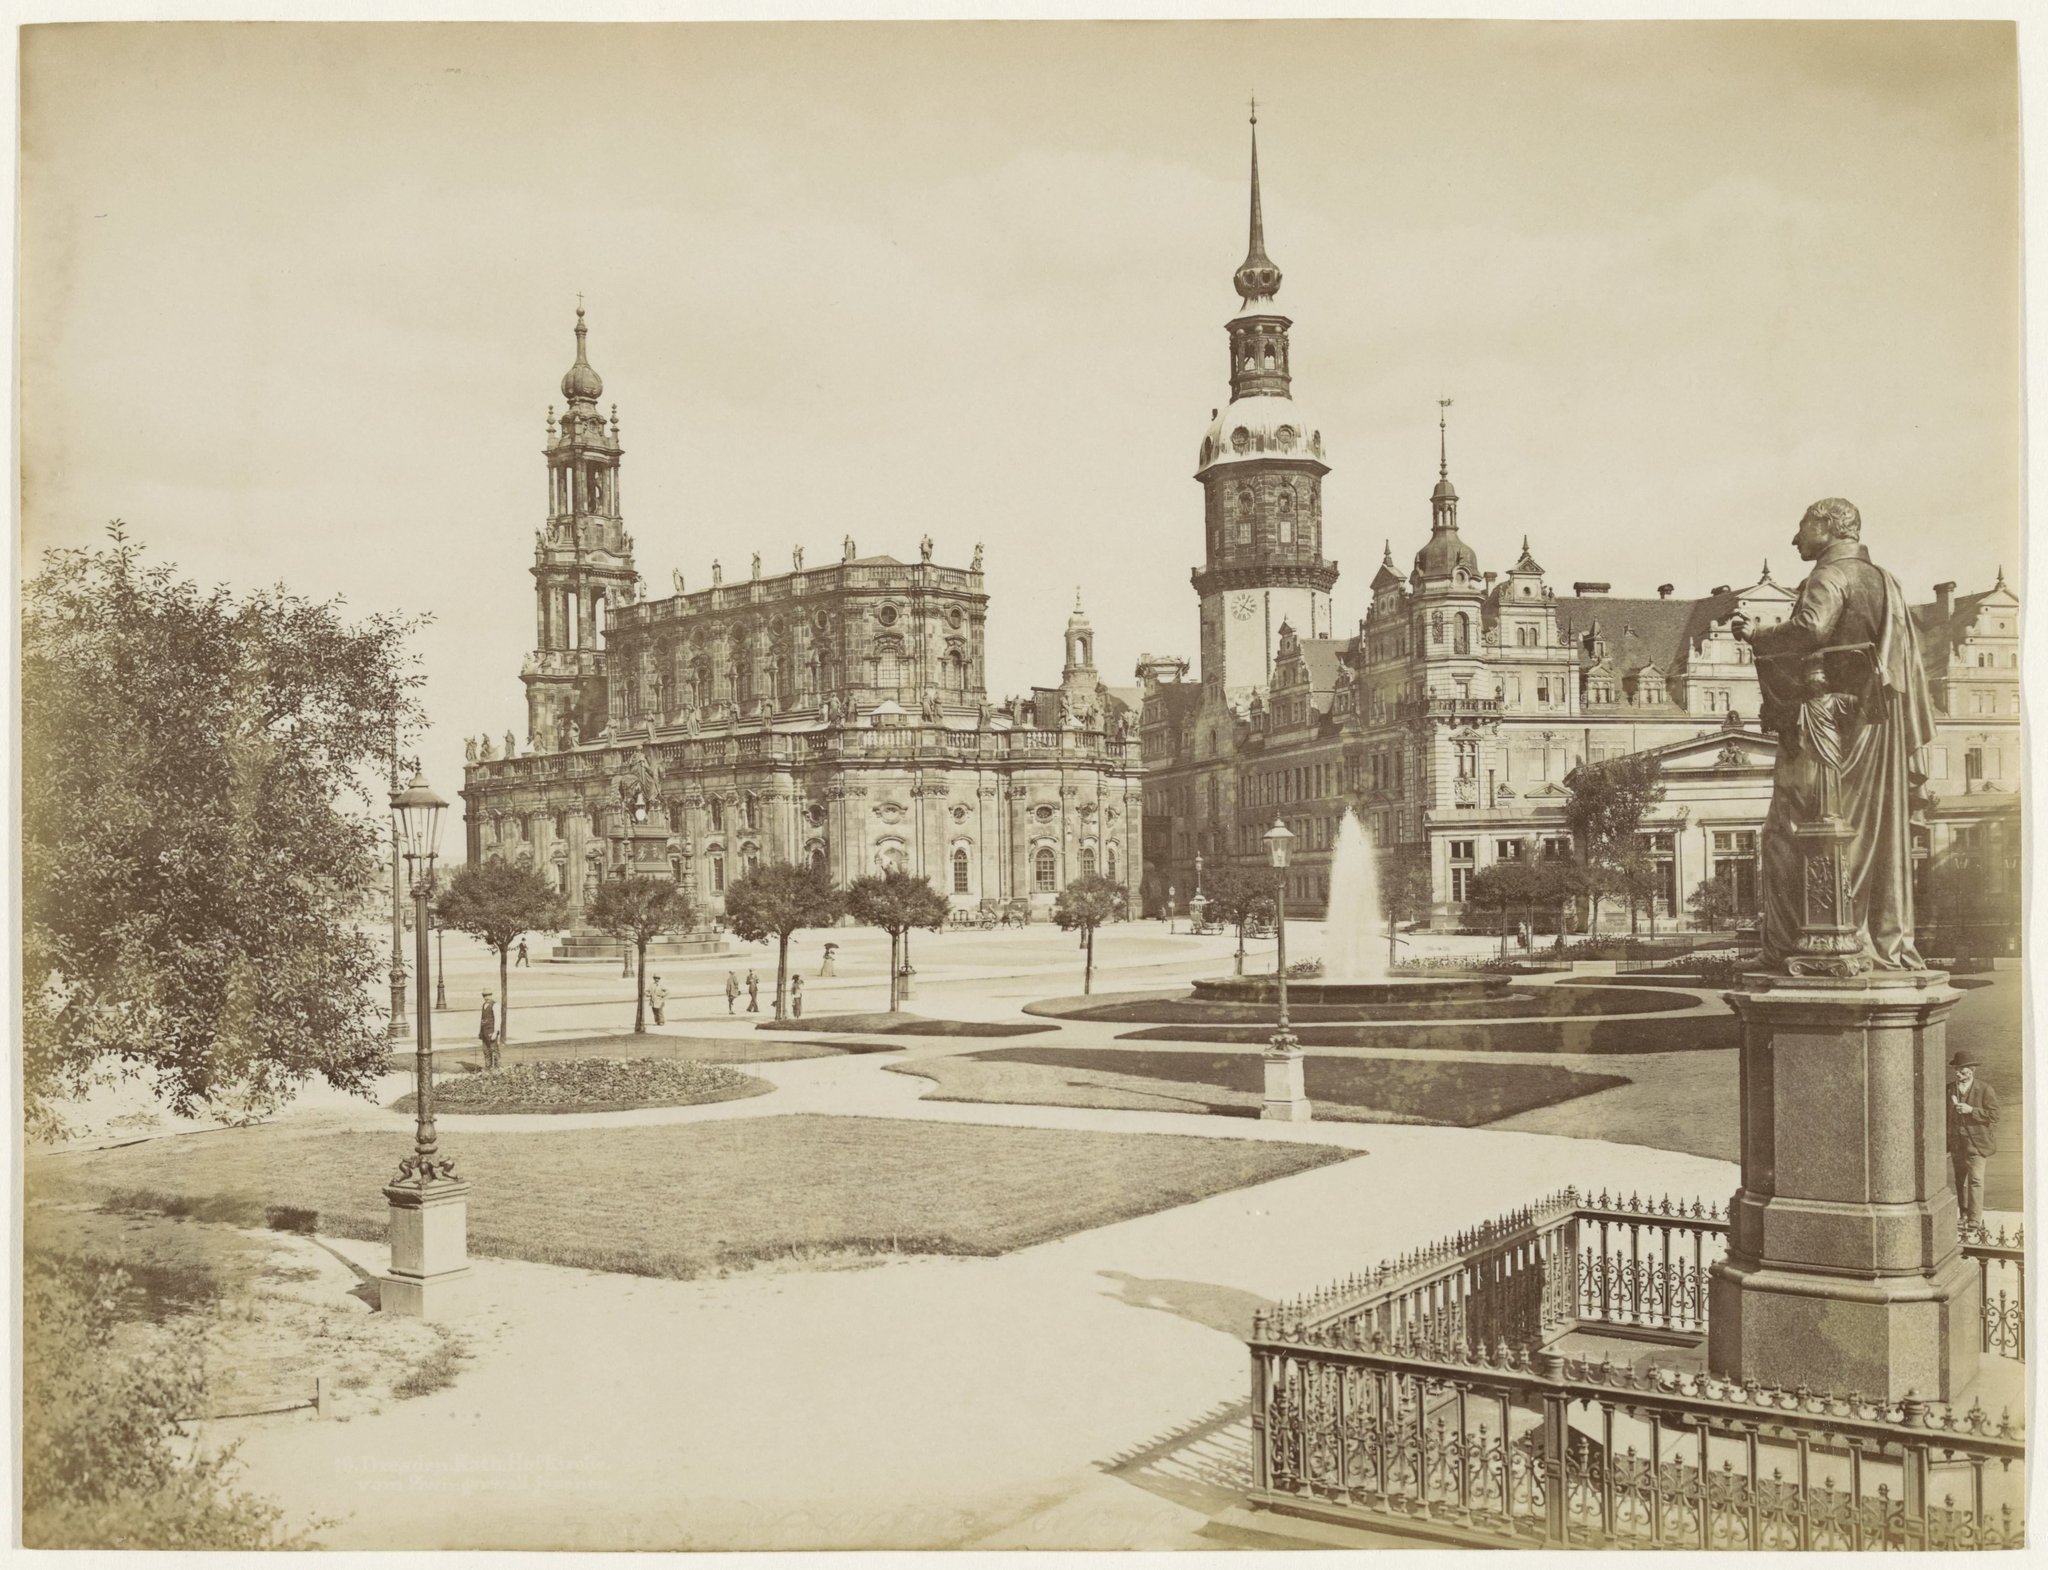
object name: photograph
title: Dresden, Kath. Hofkirche vom Zwingerwall gesehen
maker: rudolph tamme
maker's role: fotograaf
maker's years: 1835-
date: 1907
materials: paper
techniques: albumen print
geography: dresden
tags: square, place, circus, etc., church (exterior), monument, statue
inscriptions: check stamp: ‘F & O Brockmann's Nachf./ R. Tamme/ Dresden 1907’, title: ‘10. Dresden, Kath. Hofkirche/ vom Zwingerwall gesehen’